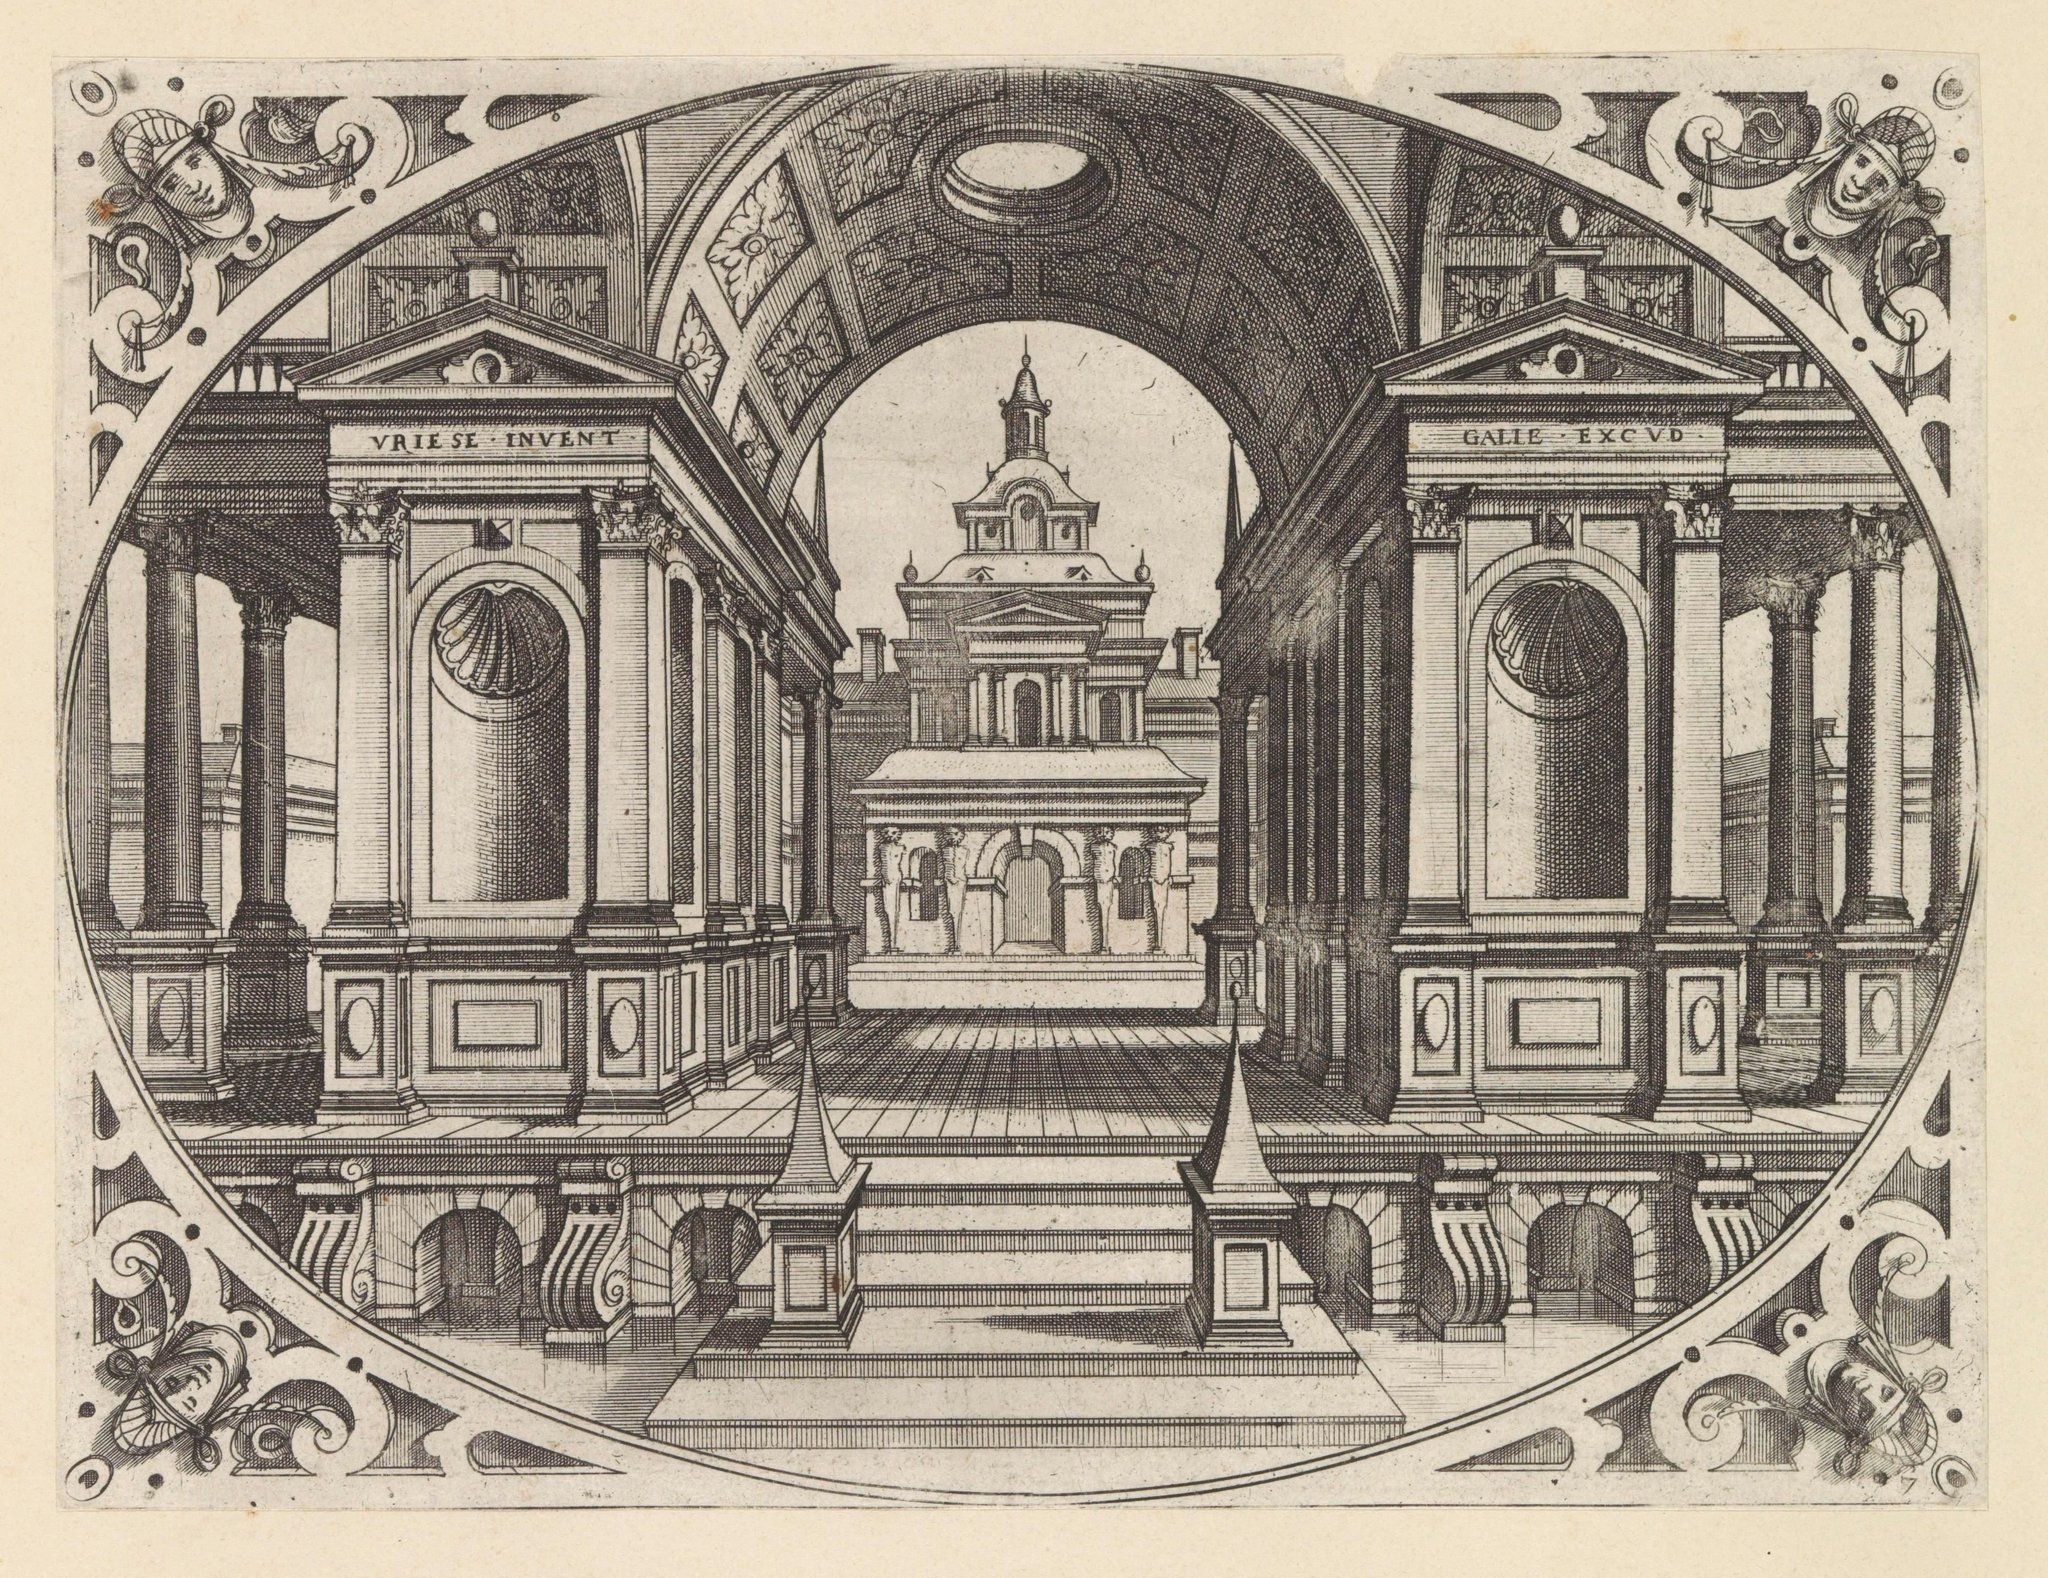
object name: ornament print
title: Architectuurperspectieven in ovale omlijstingen voor intarsia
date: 1601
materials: paper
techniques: etching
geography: antwerp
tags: architectural representations in general, gate, entrance, vault ~ architecture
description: Portaal met een tongewelf, voorzien van een oculus. Links en rechts lege muurnissen. Op de achtergrond een stadspoort met hermen. In de hoeken rolwerk met maskers. De prent maakt deel uit van een album.